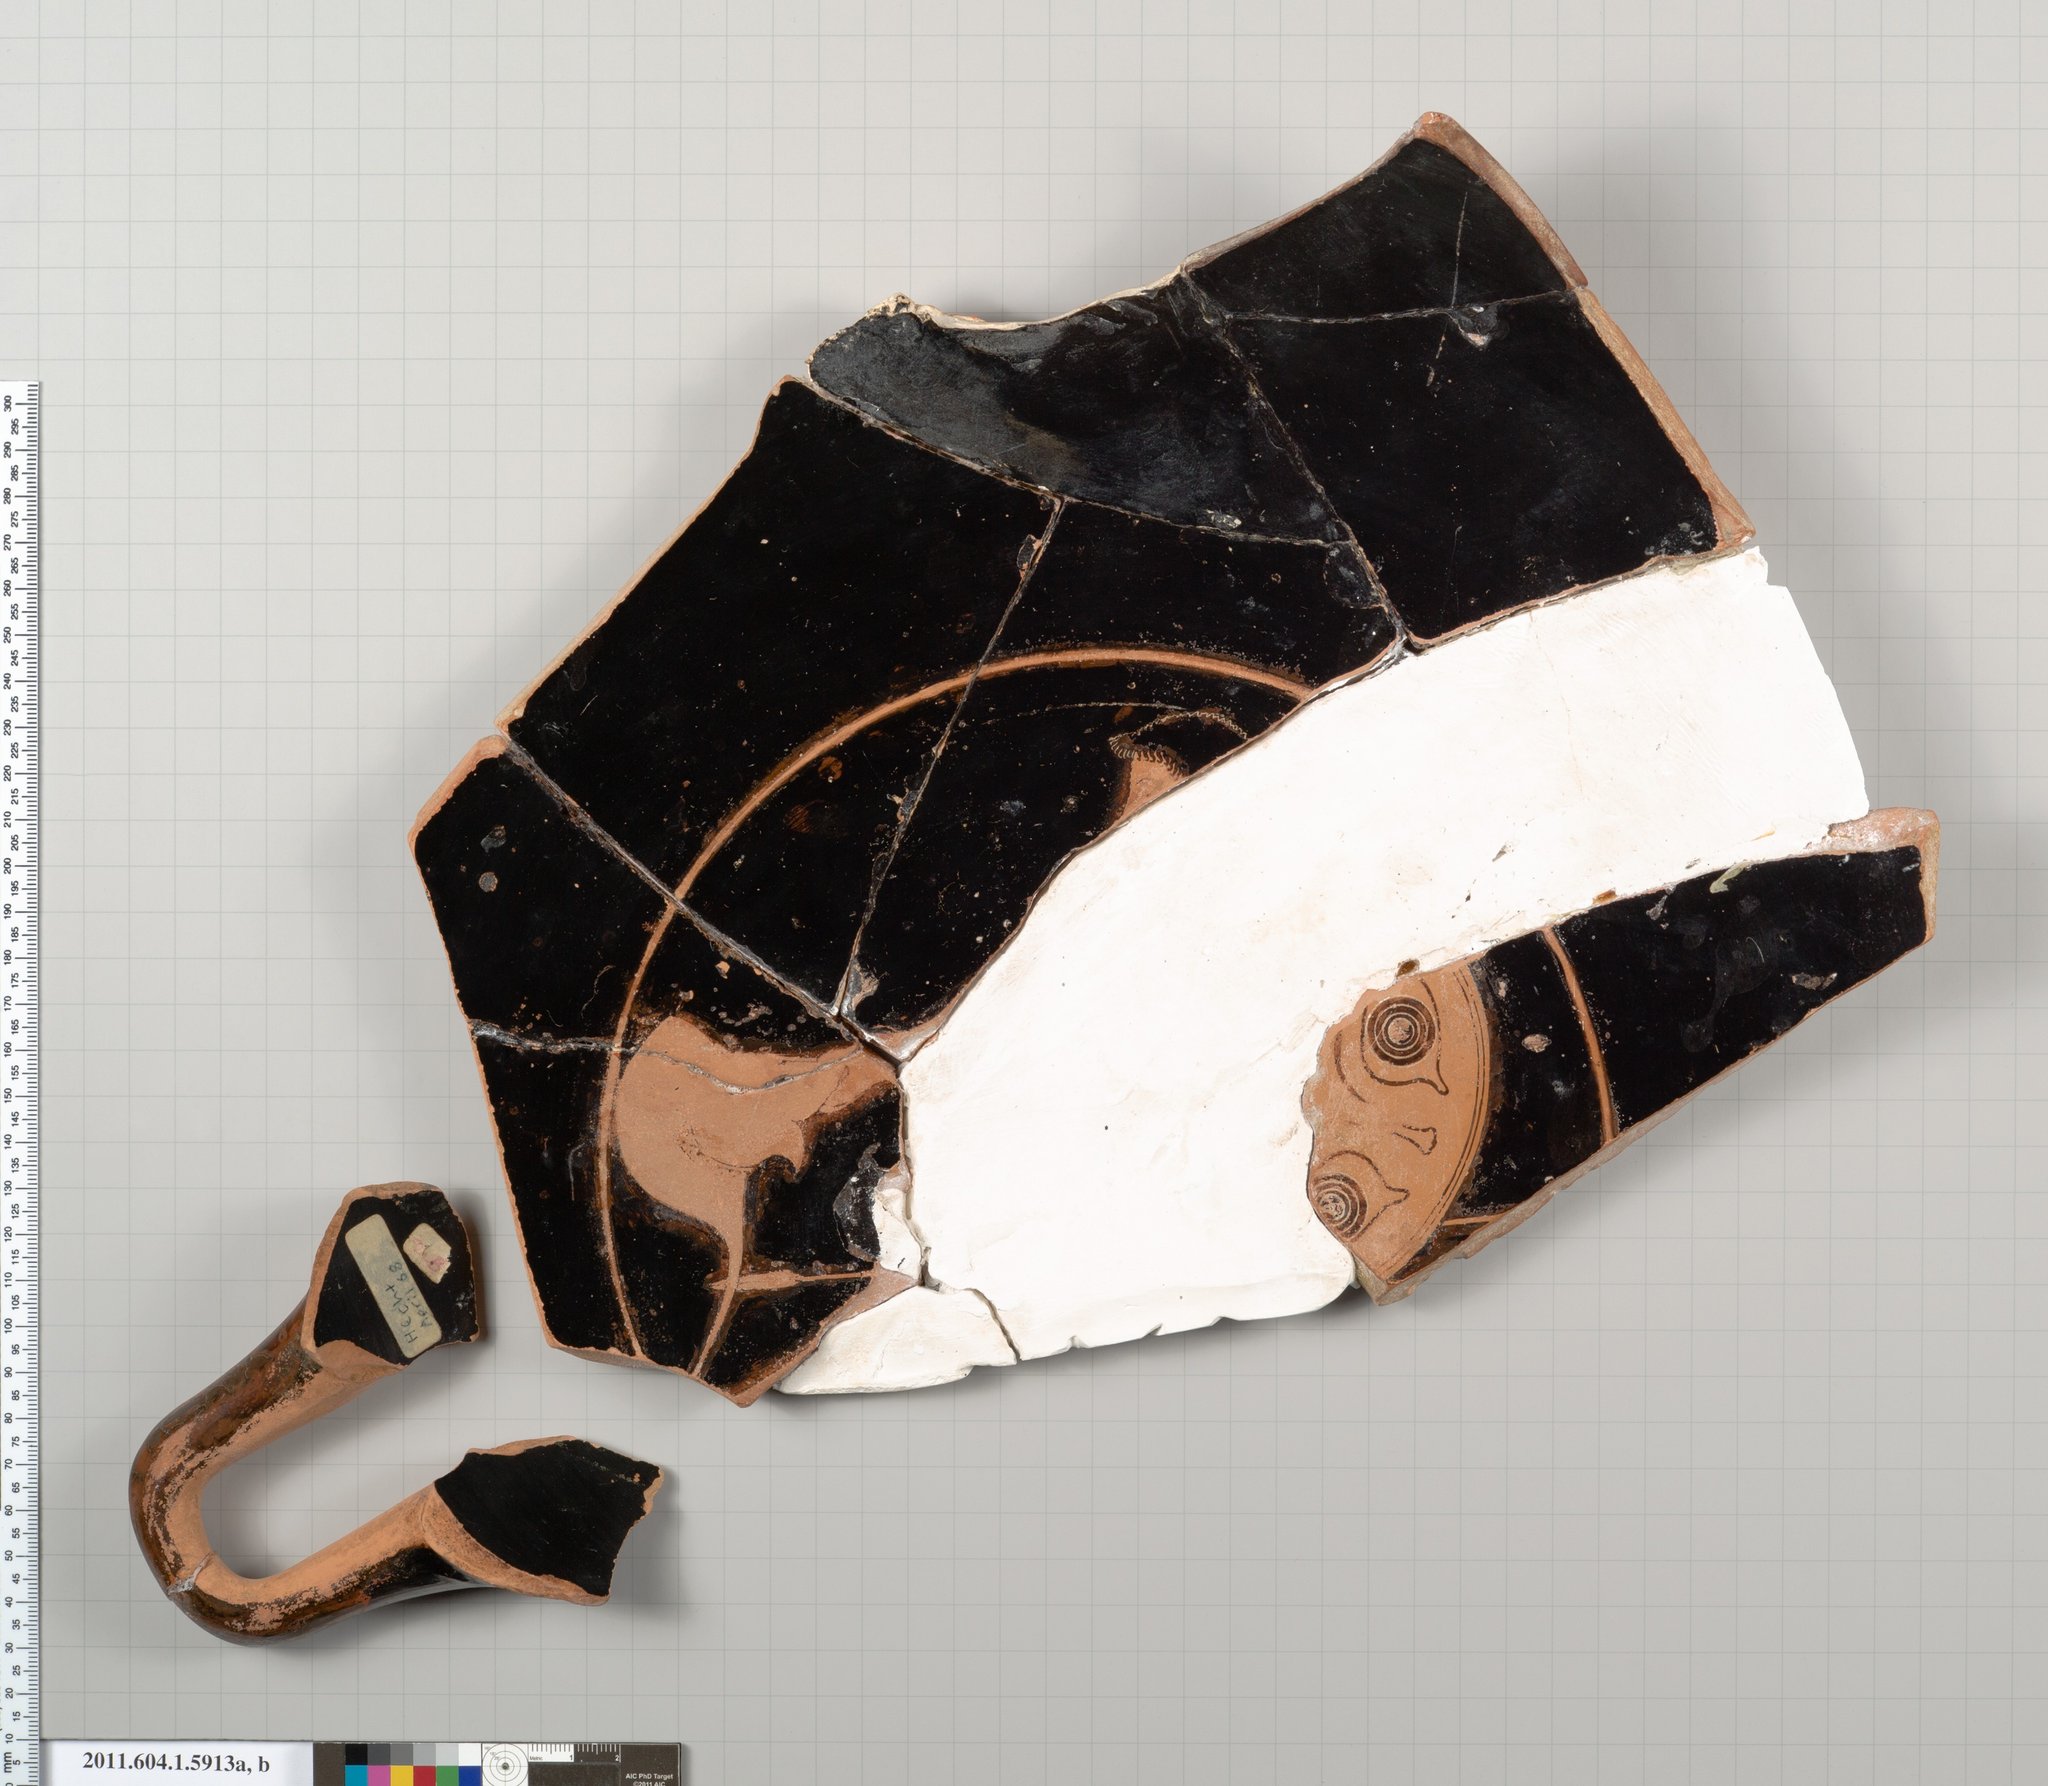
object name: kylix fragment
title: Terracotta fragments of a kylix (drinking cup)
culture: greek, attic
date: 520-510 BCE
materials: terracotta